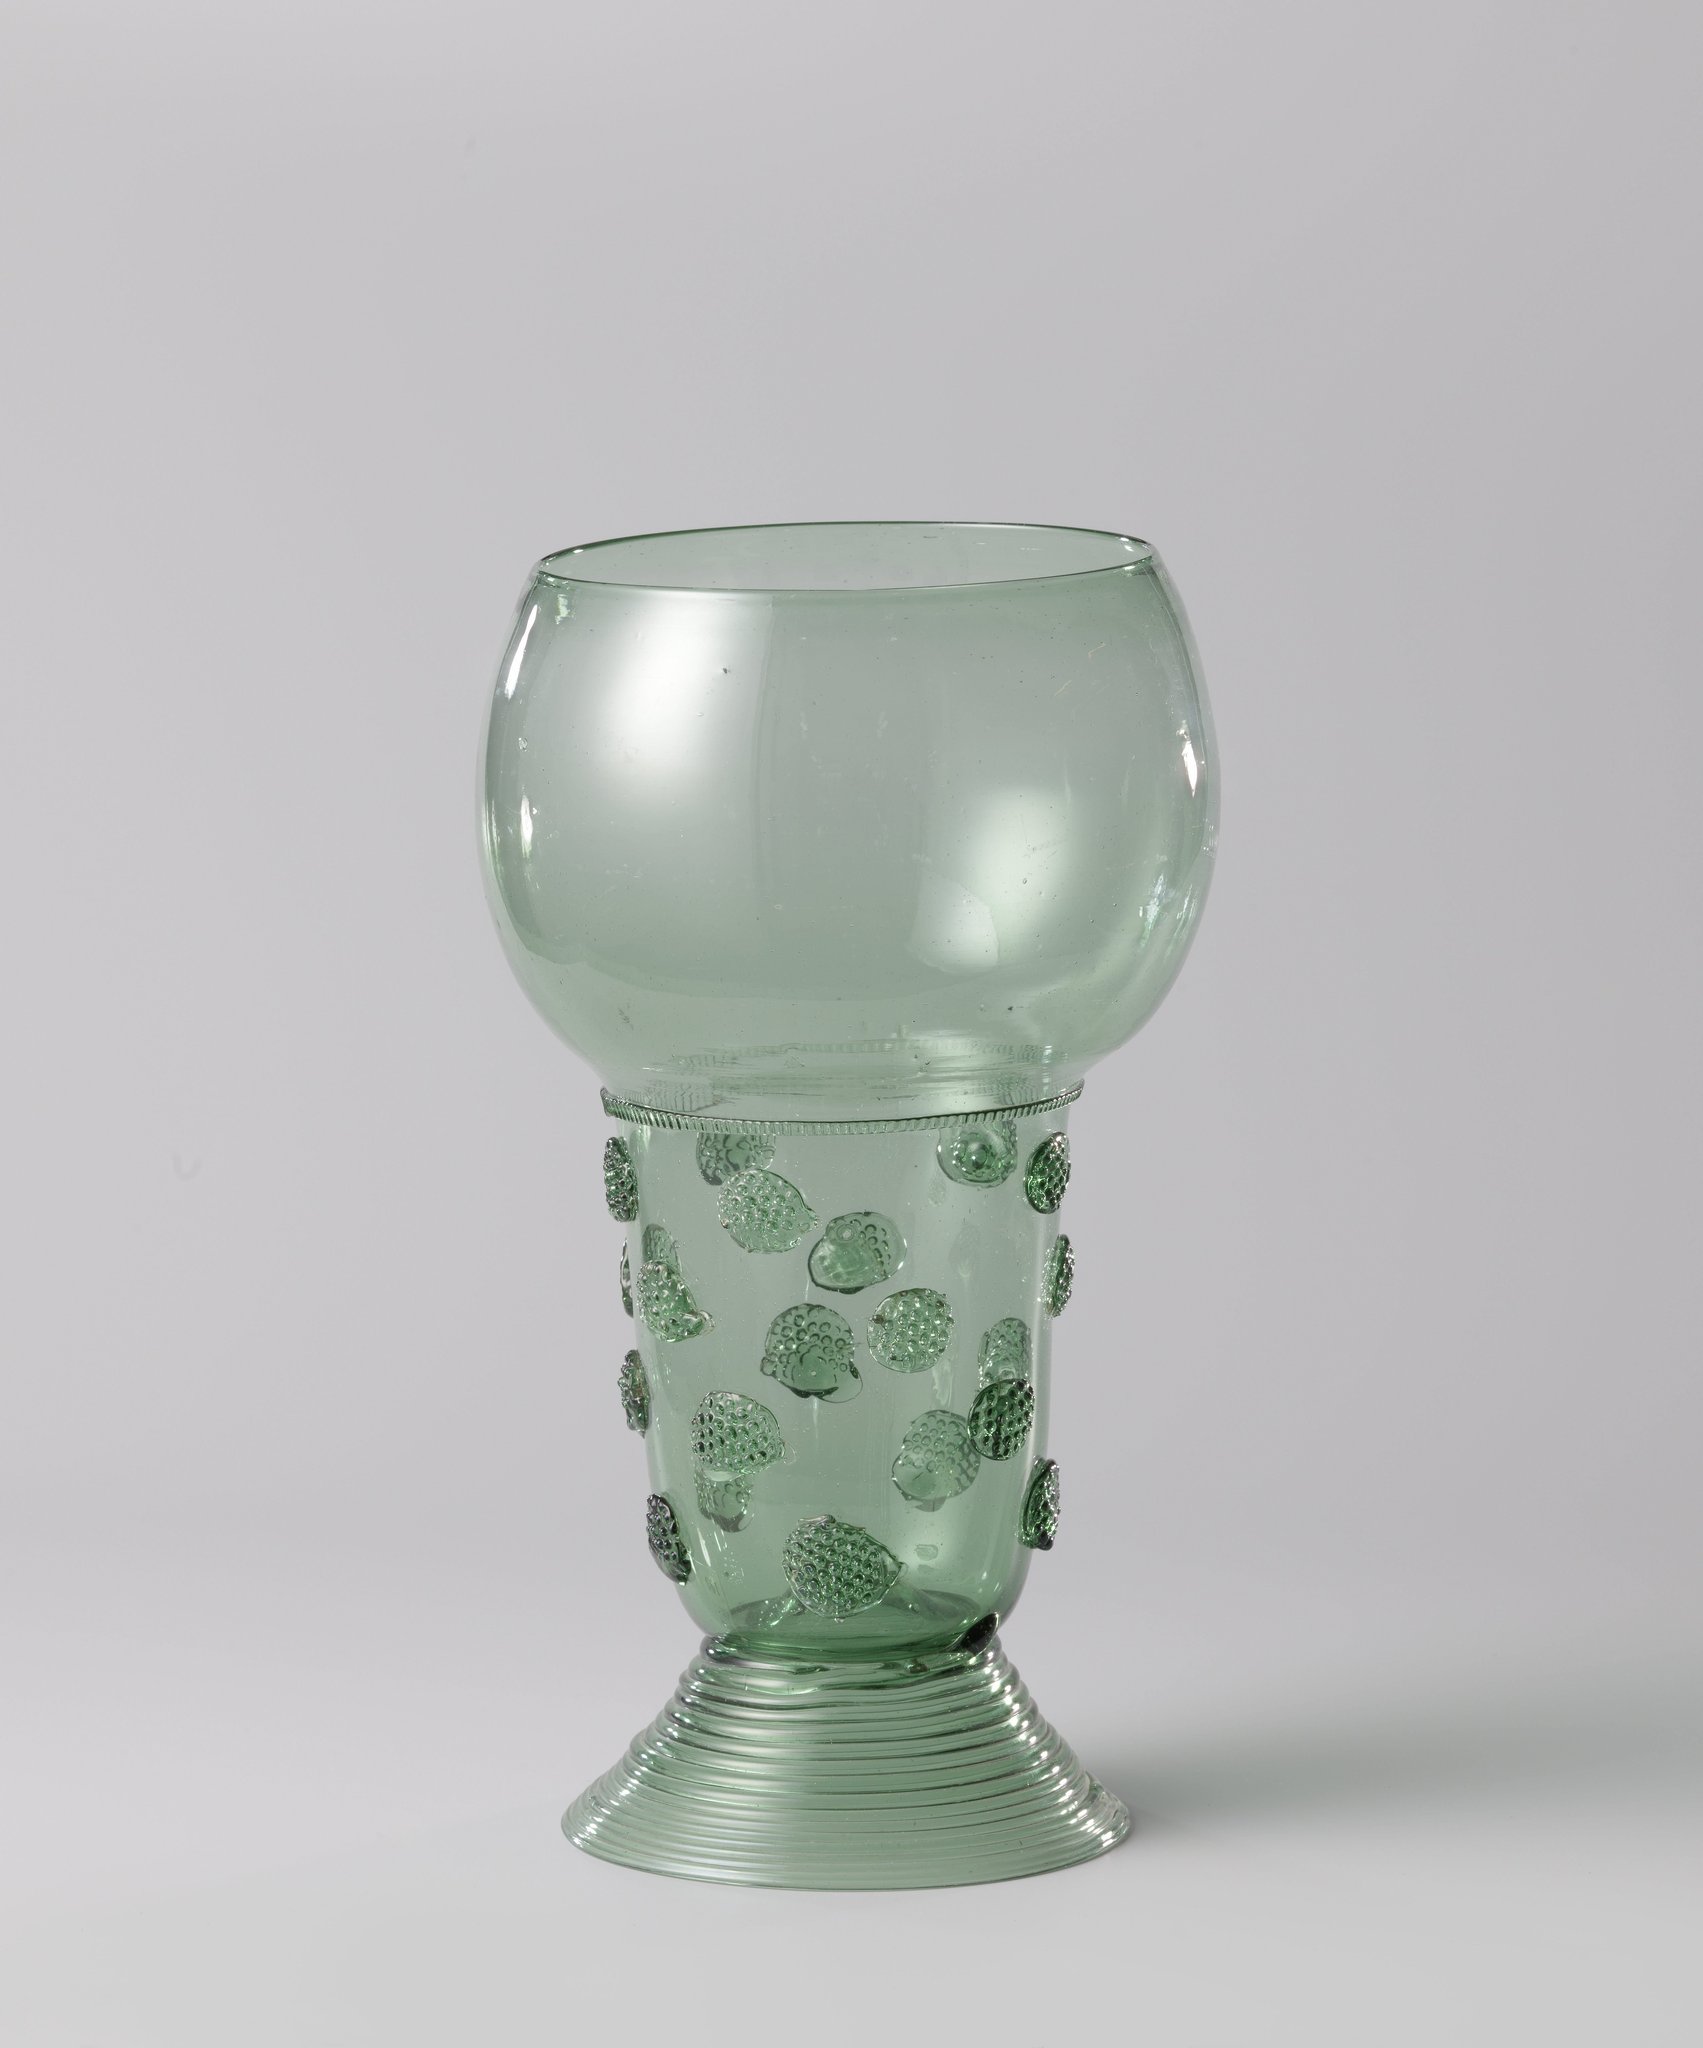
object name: roemer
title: Roemer met vier rijen braamnoppen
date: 1650-1675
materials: glass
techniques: glassblowing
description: Grote roemer met ingestoken bodem op conische, uit een draad gesponnen voet. De bolle kelk als één geheel geblazen met de stam, die bezet is met vier rijen kleine braamnoppen. De overgang van de kelk naar de stam aangegeven door een geribde draad